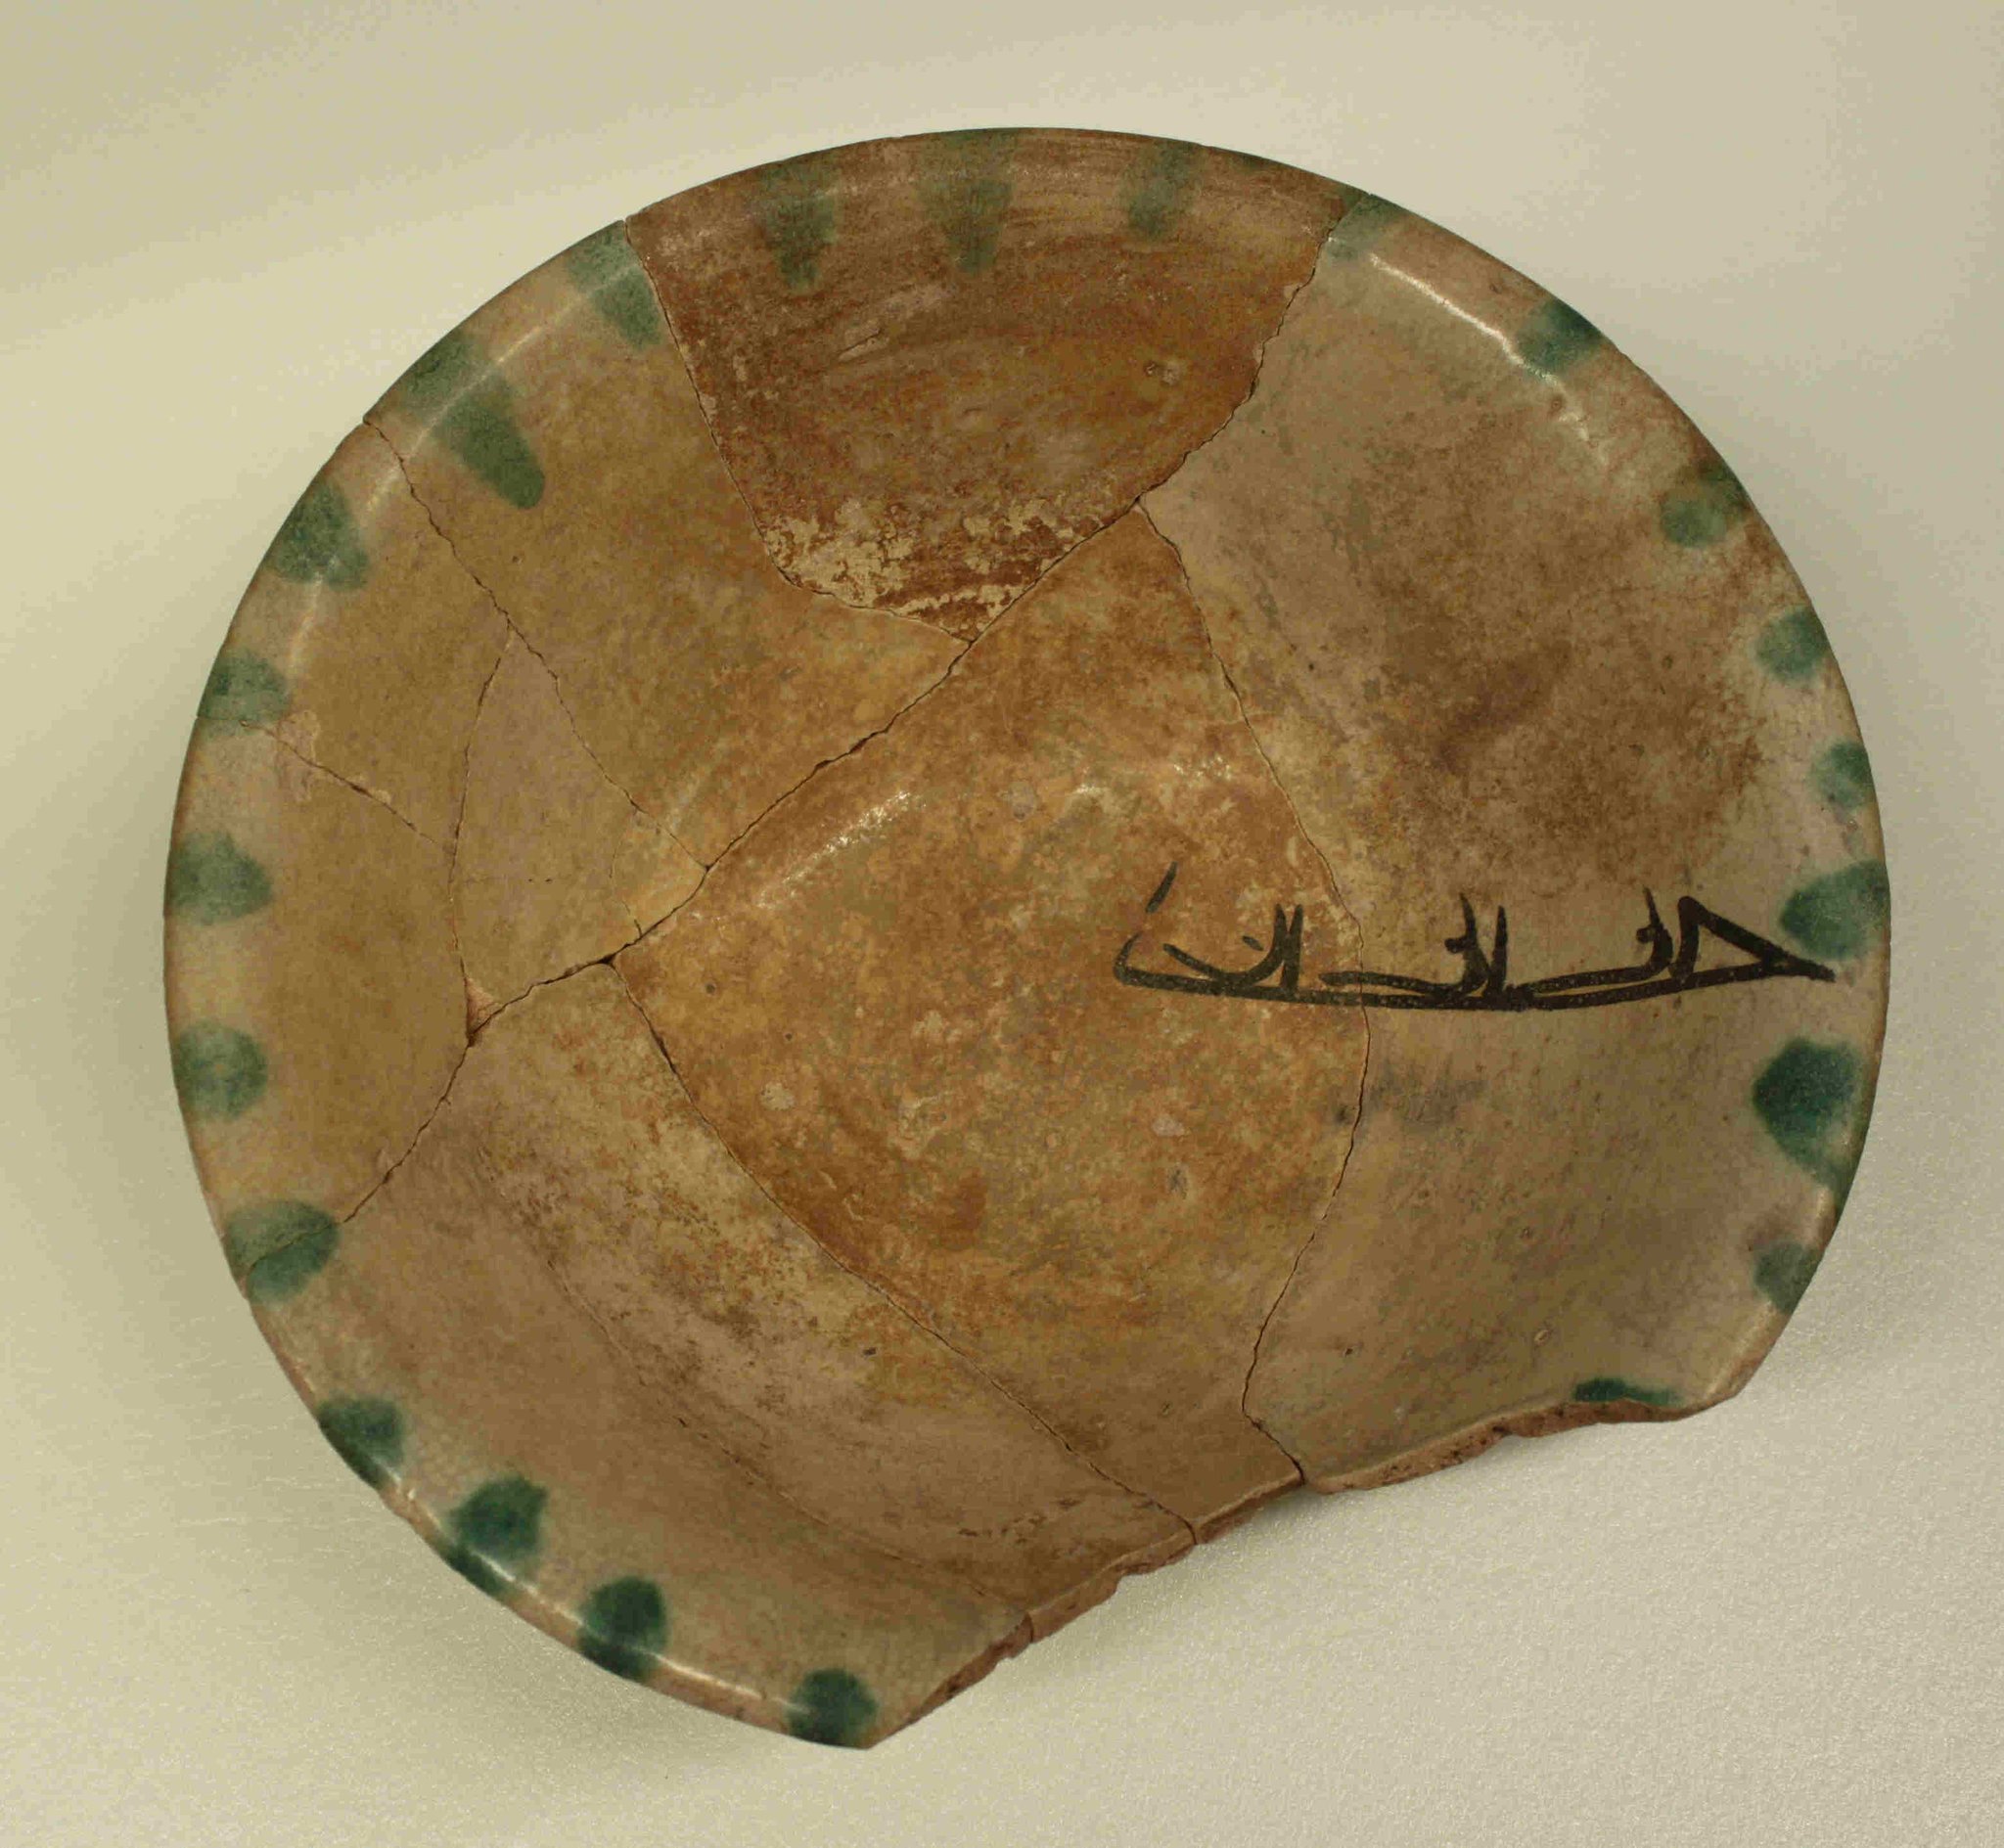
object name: bowl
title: Bowl with Inscription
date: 801-900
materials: earthenware, glaze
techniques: painting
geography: iran